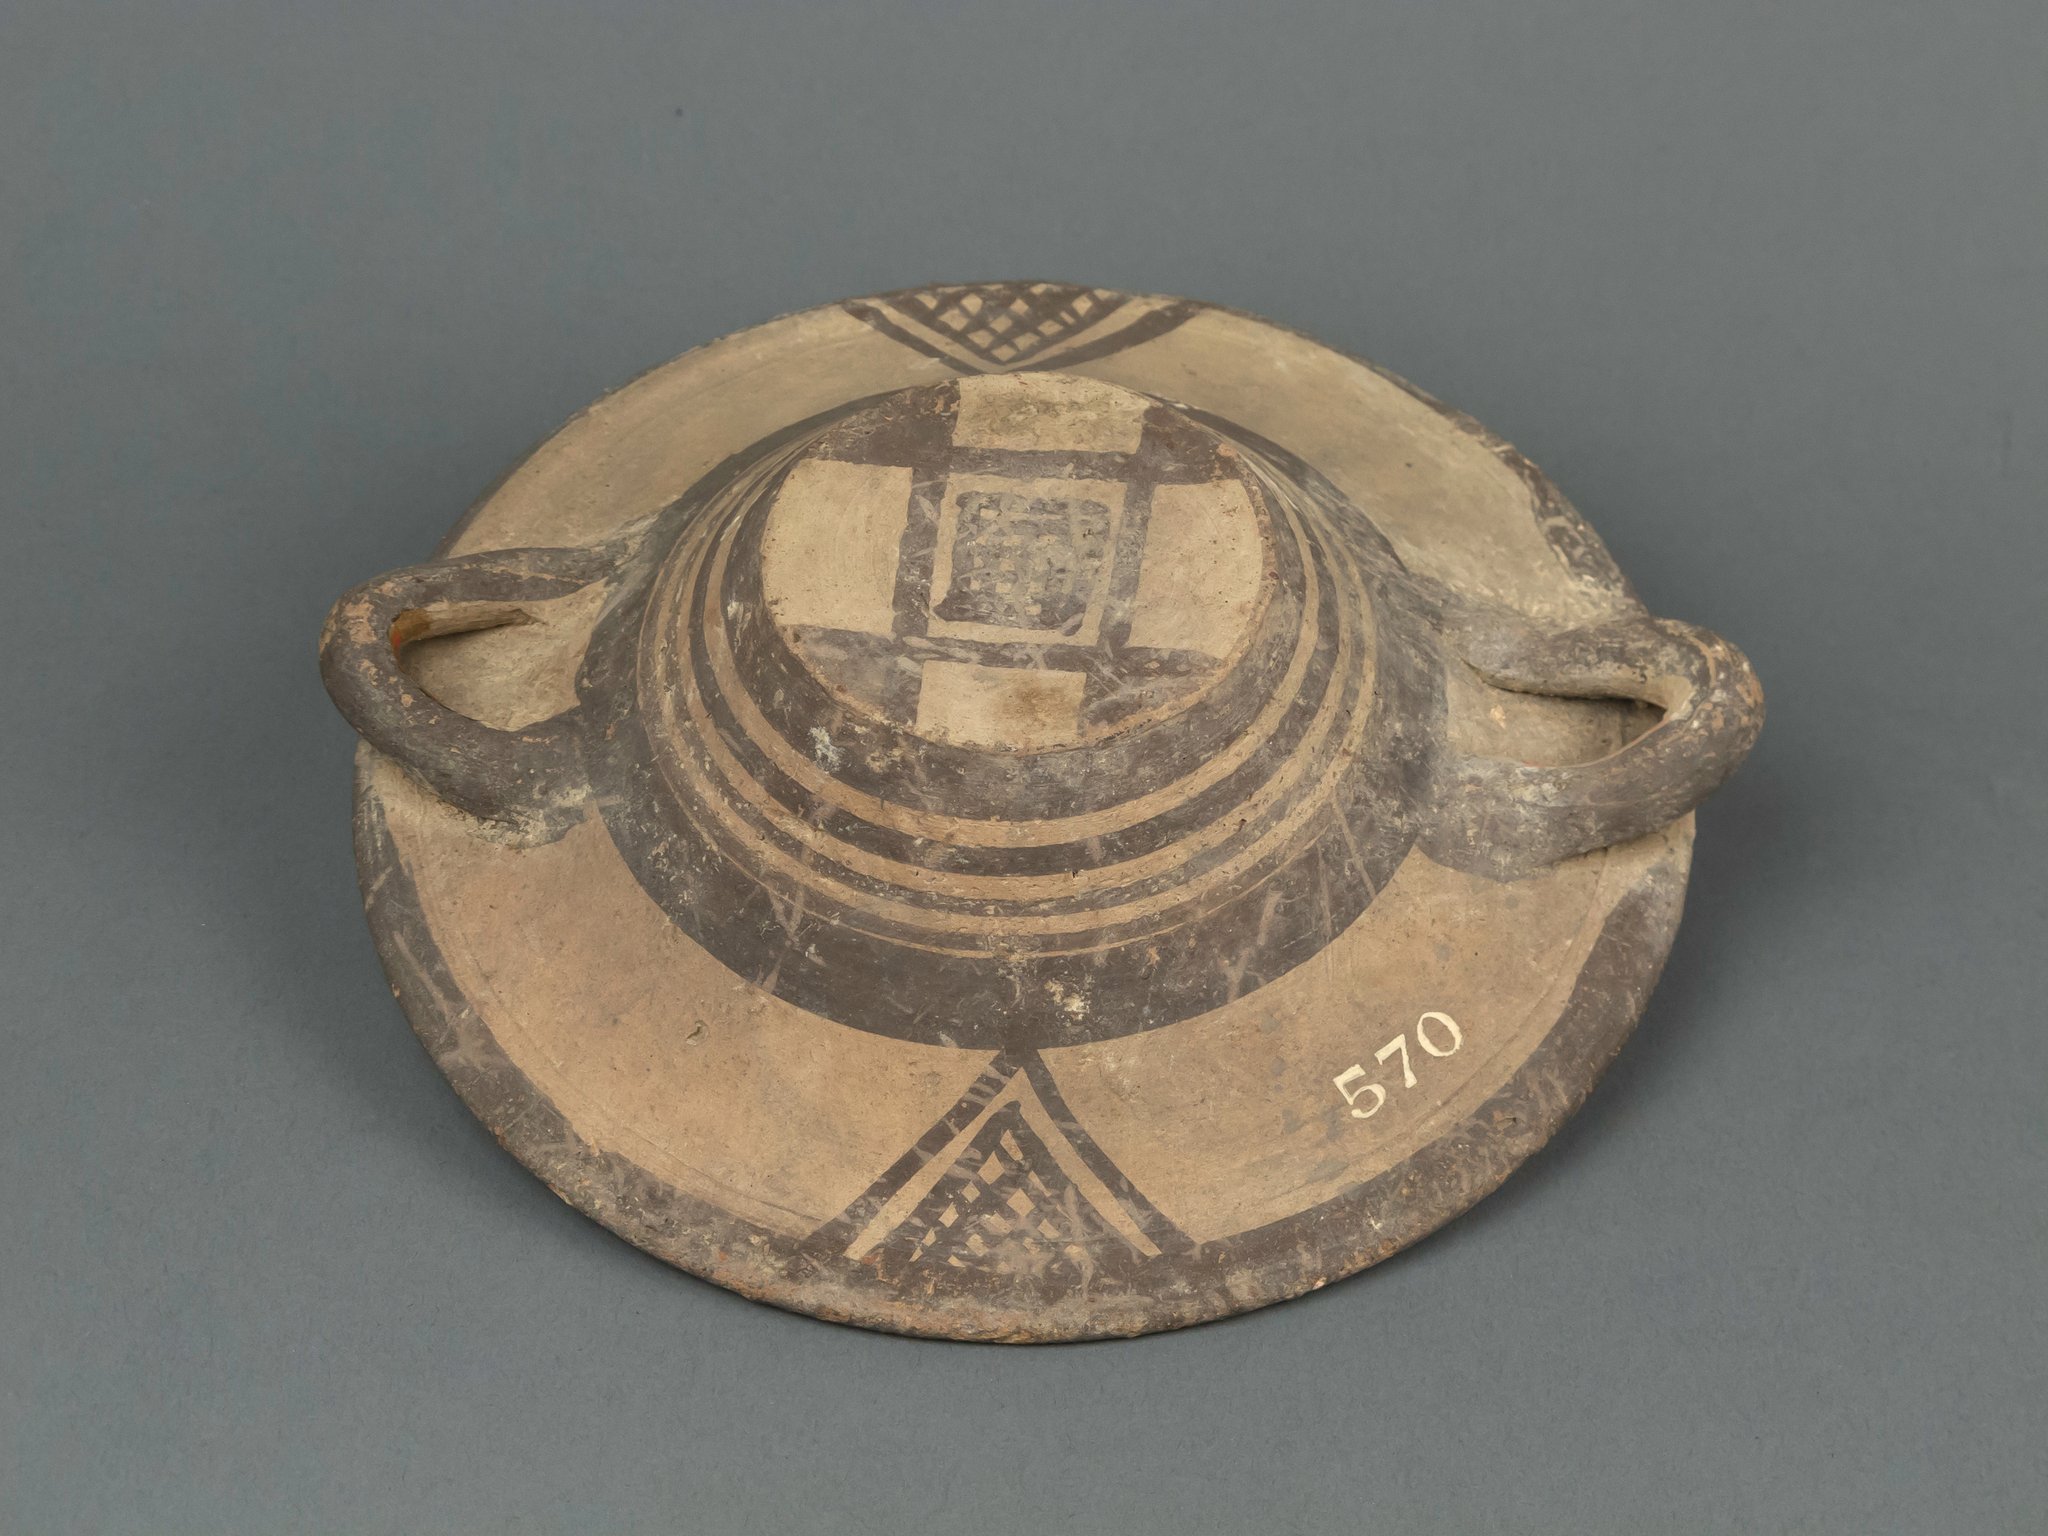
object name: kalathos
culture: cypriot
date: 1050-950 BCE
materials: terracotta